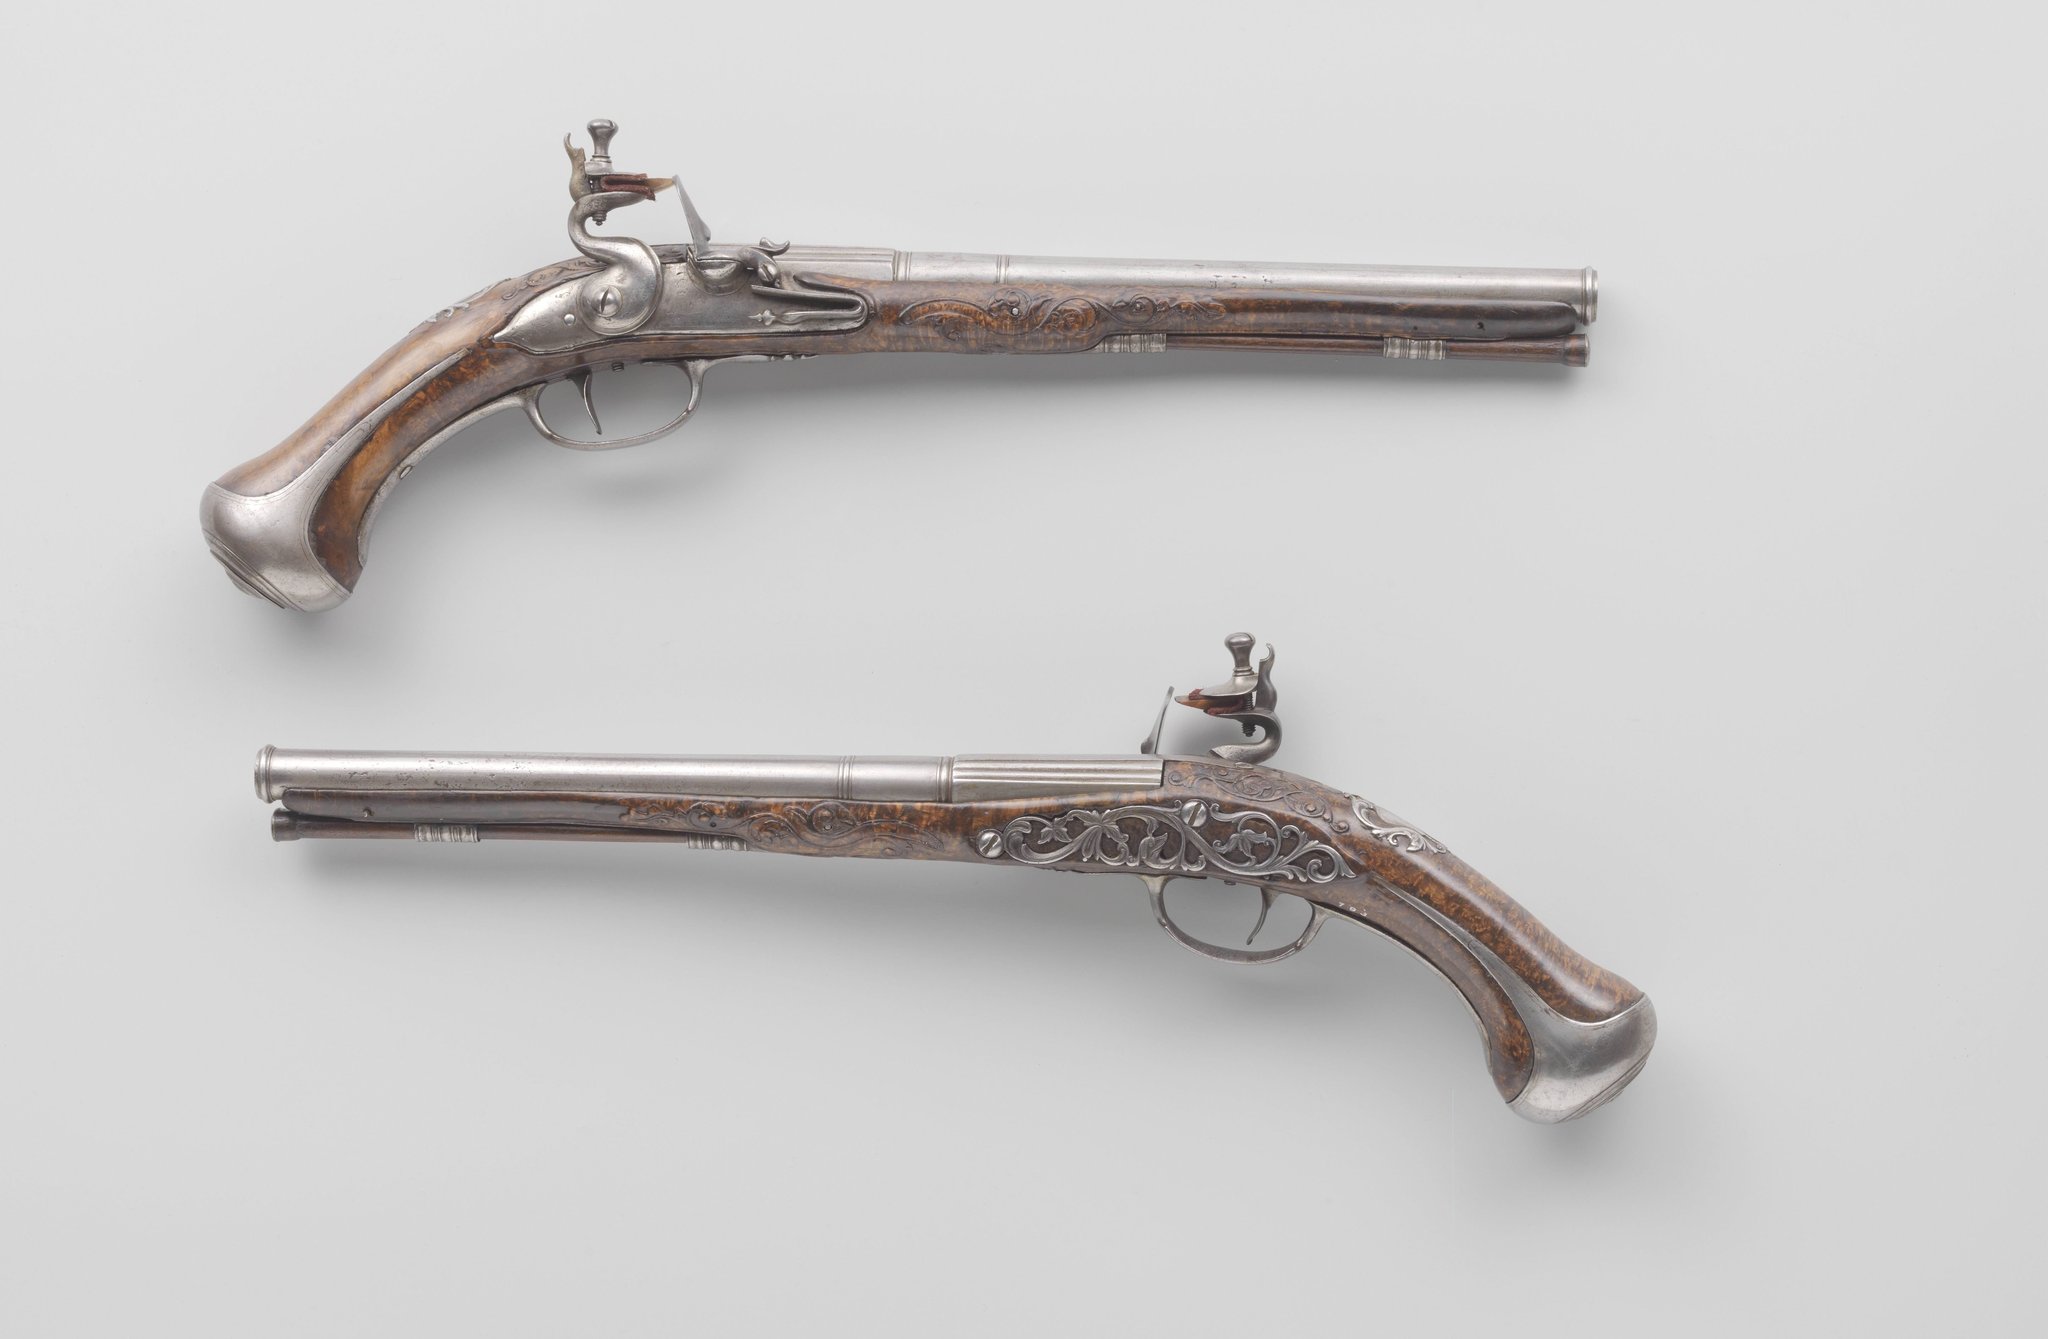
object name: flintlock pistol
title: Vuursteenpistool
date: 1665-1670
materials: iron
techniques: printing, casting, cutting, embroidery, engraving, relief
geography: utrecht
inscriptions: mark: ‘AI’, inscription: ‘IAN KNOOP // UTRECHT’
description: Jan Knoop maakte het slot, Abraham Janssen heeft het pistool geassembleerd.